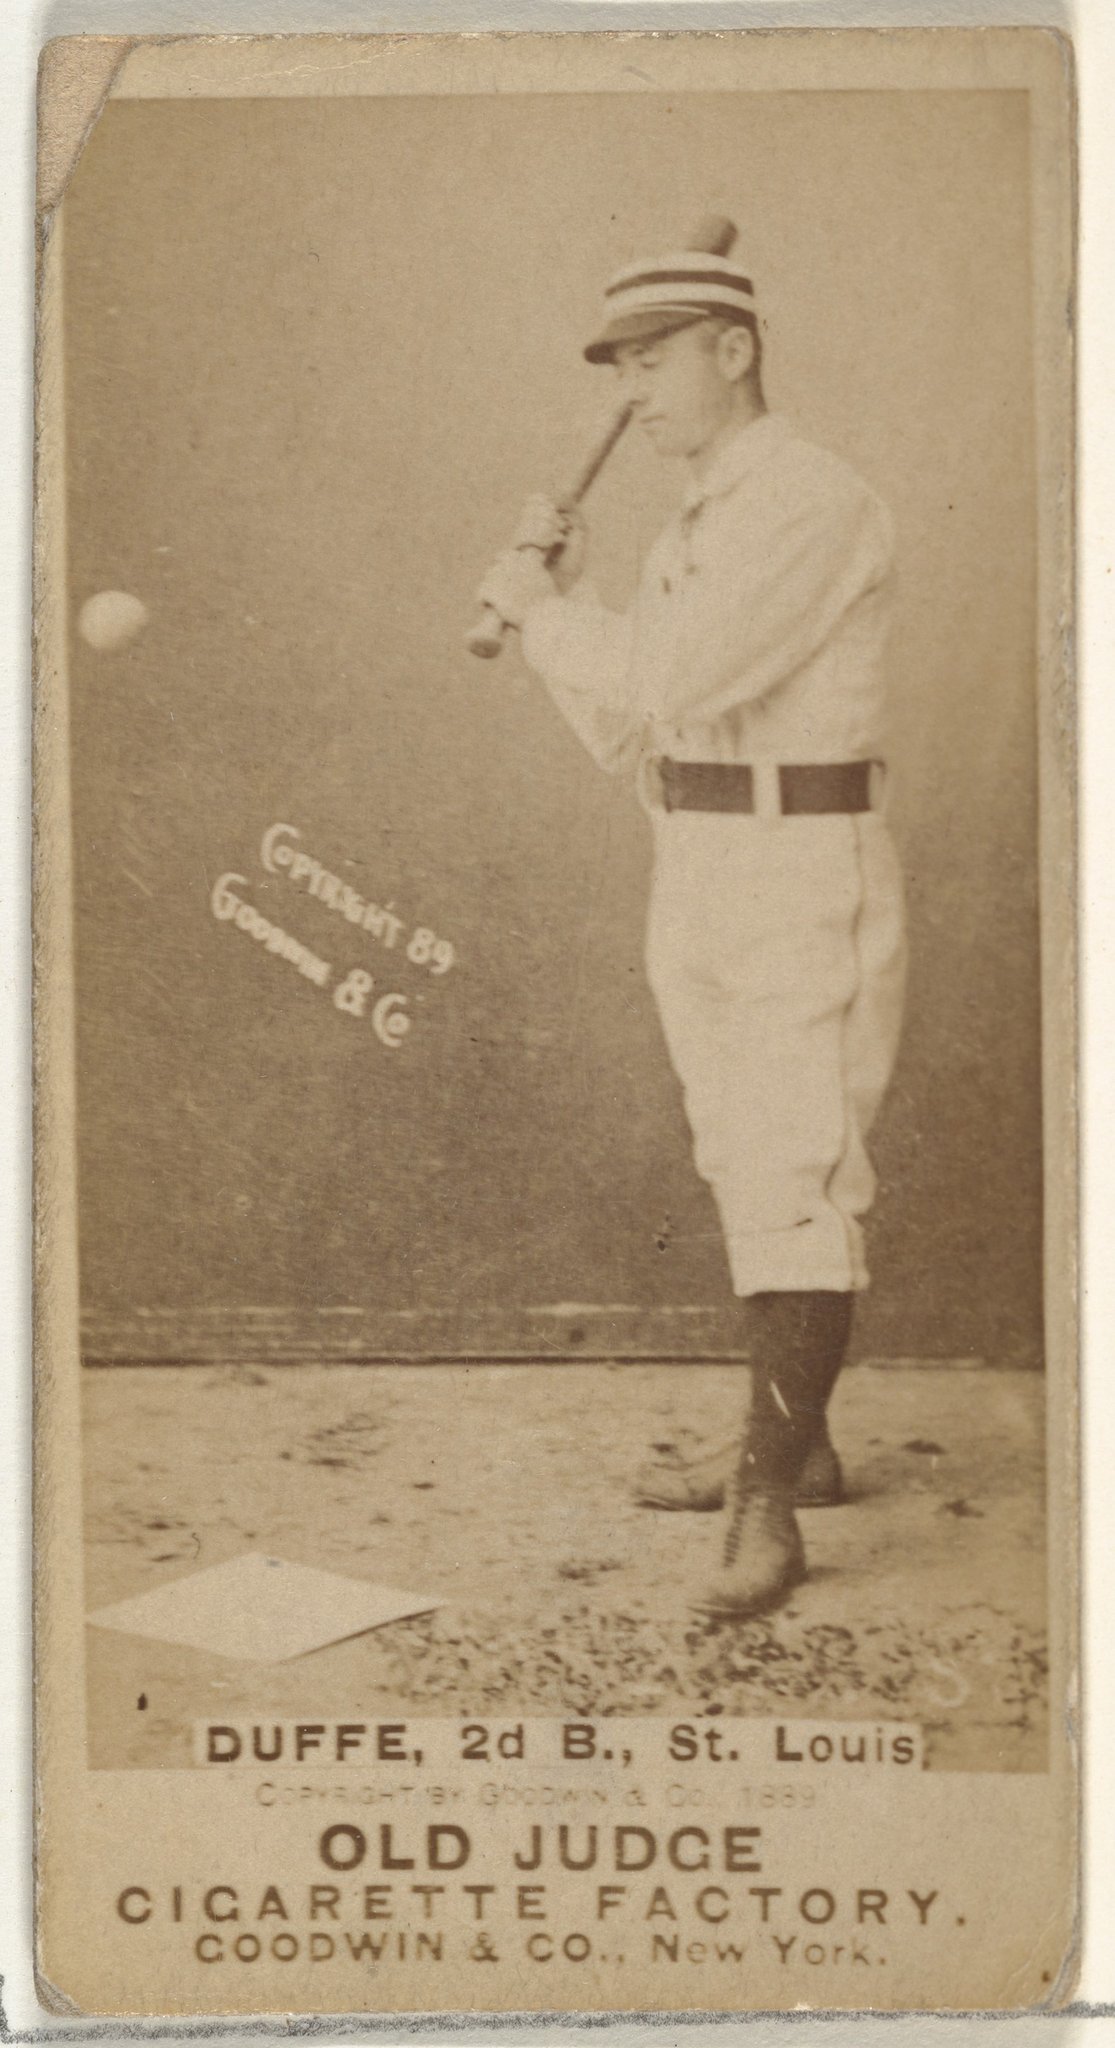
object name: baseball card, photograph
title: Charles Edward "Charlie" Duffee, 2nd Base, St. Louis Browns, from the Old Judge series (N172) for Old Judge Cigarettes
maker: goodwin & company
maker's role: publisher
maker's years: 1850-1950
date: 1889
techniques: albumen silver print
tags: men,portraits,baseball,athletes